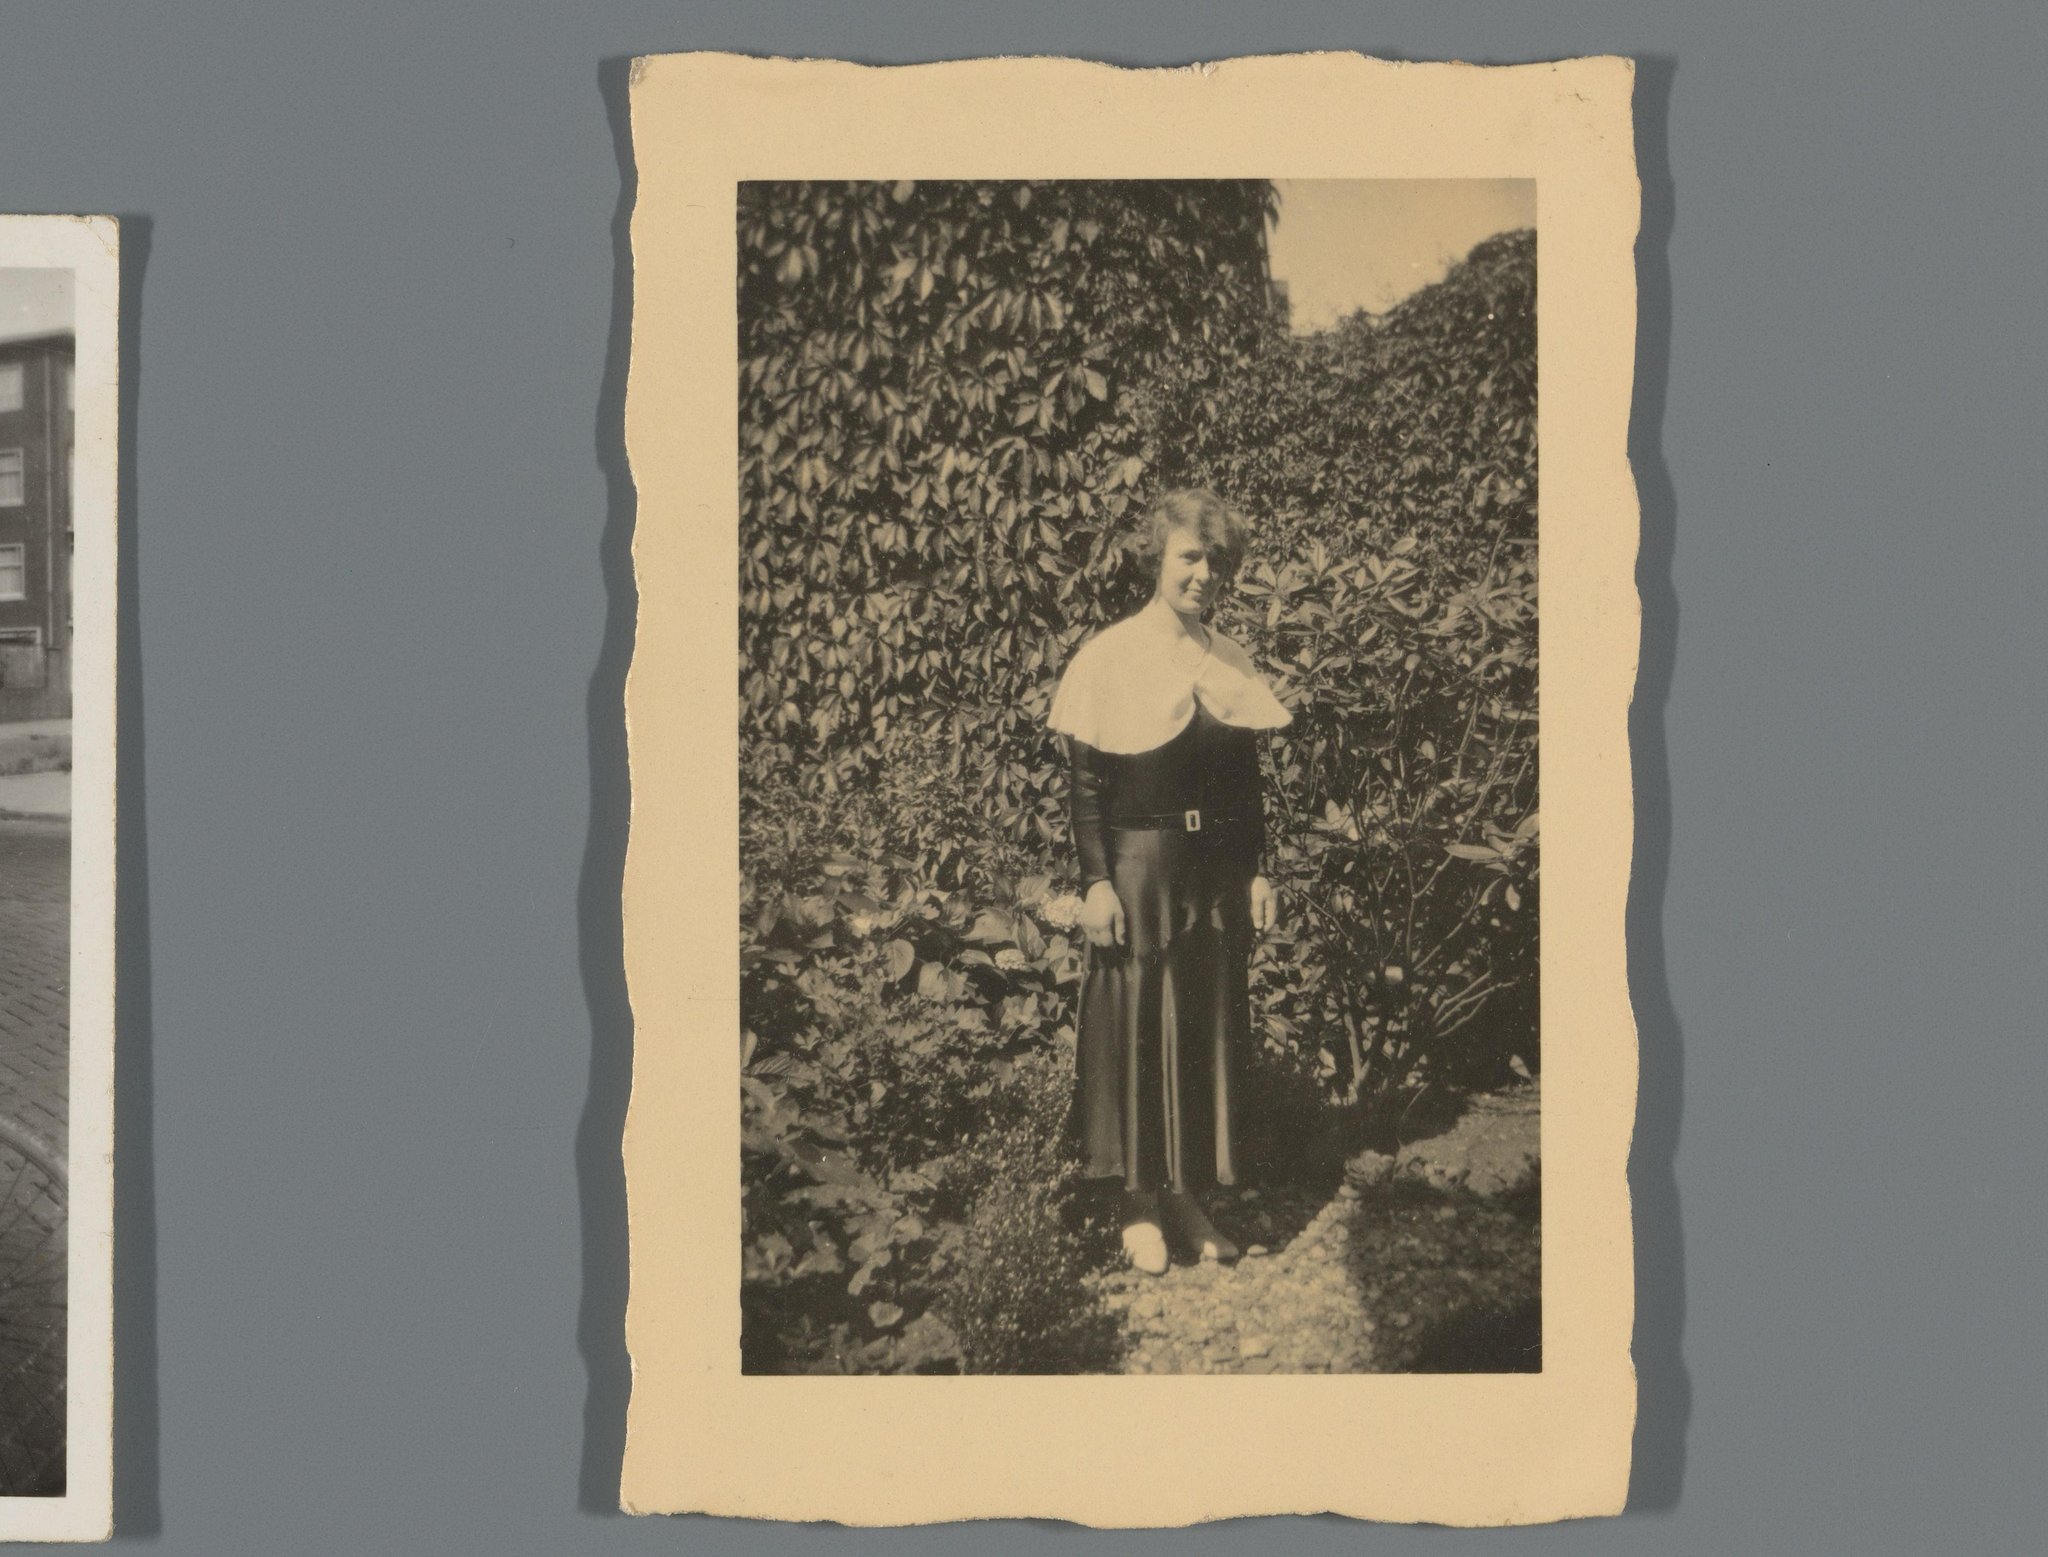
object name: photograph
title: Portret van een onbekende vrouw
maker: Anonymous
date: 1920-1940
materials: paper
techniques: gelatin silver print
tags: anonymous historical person portrayed - bb - woman